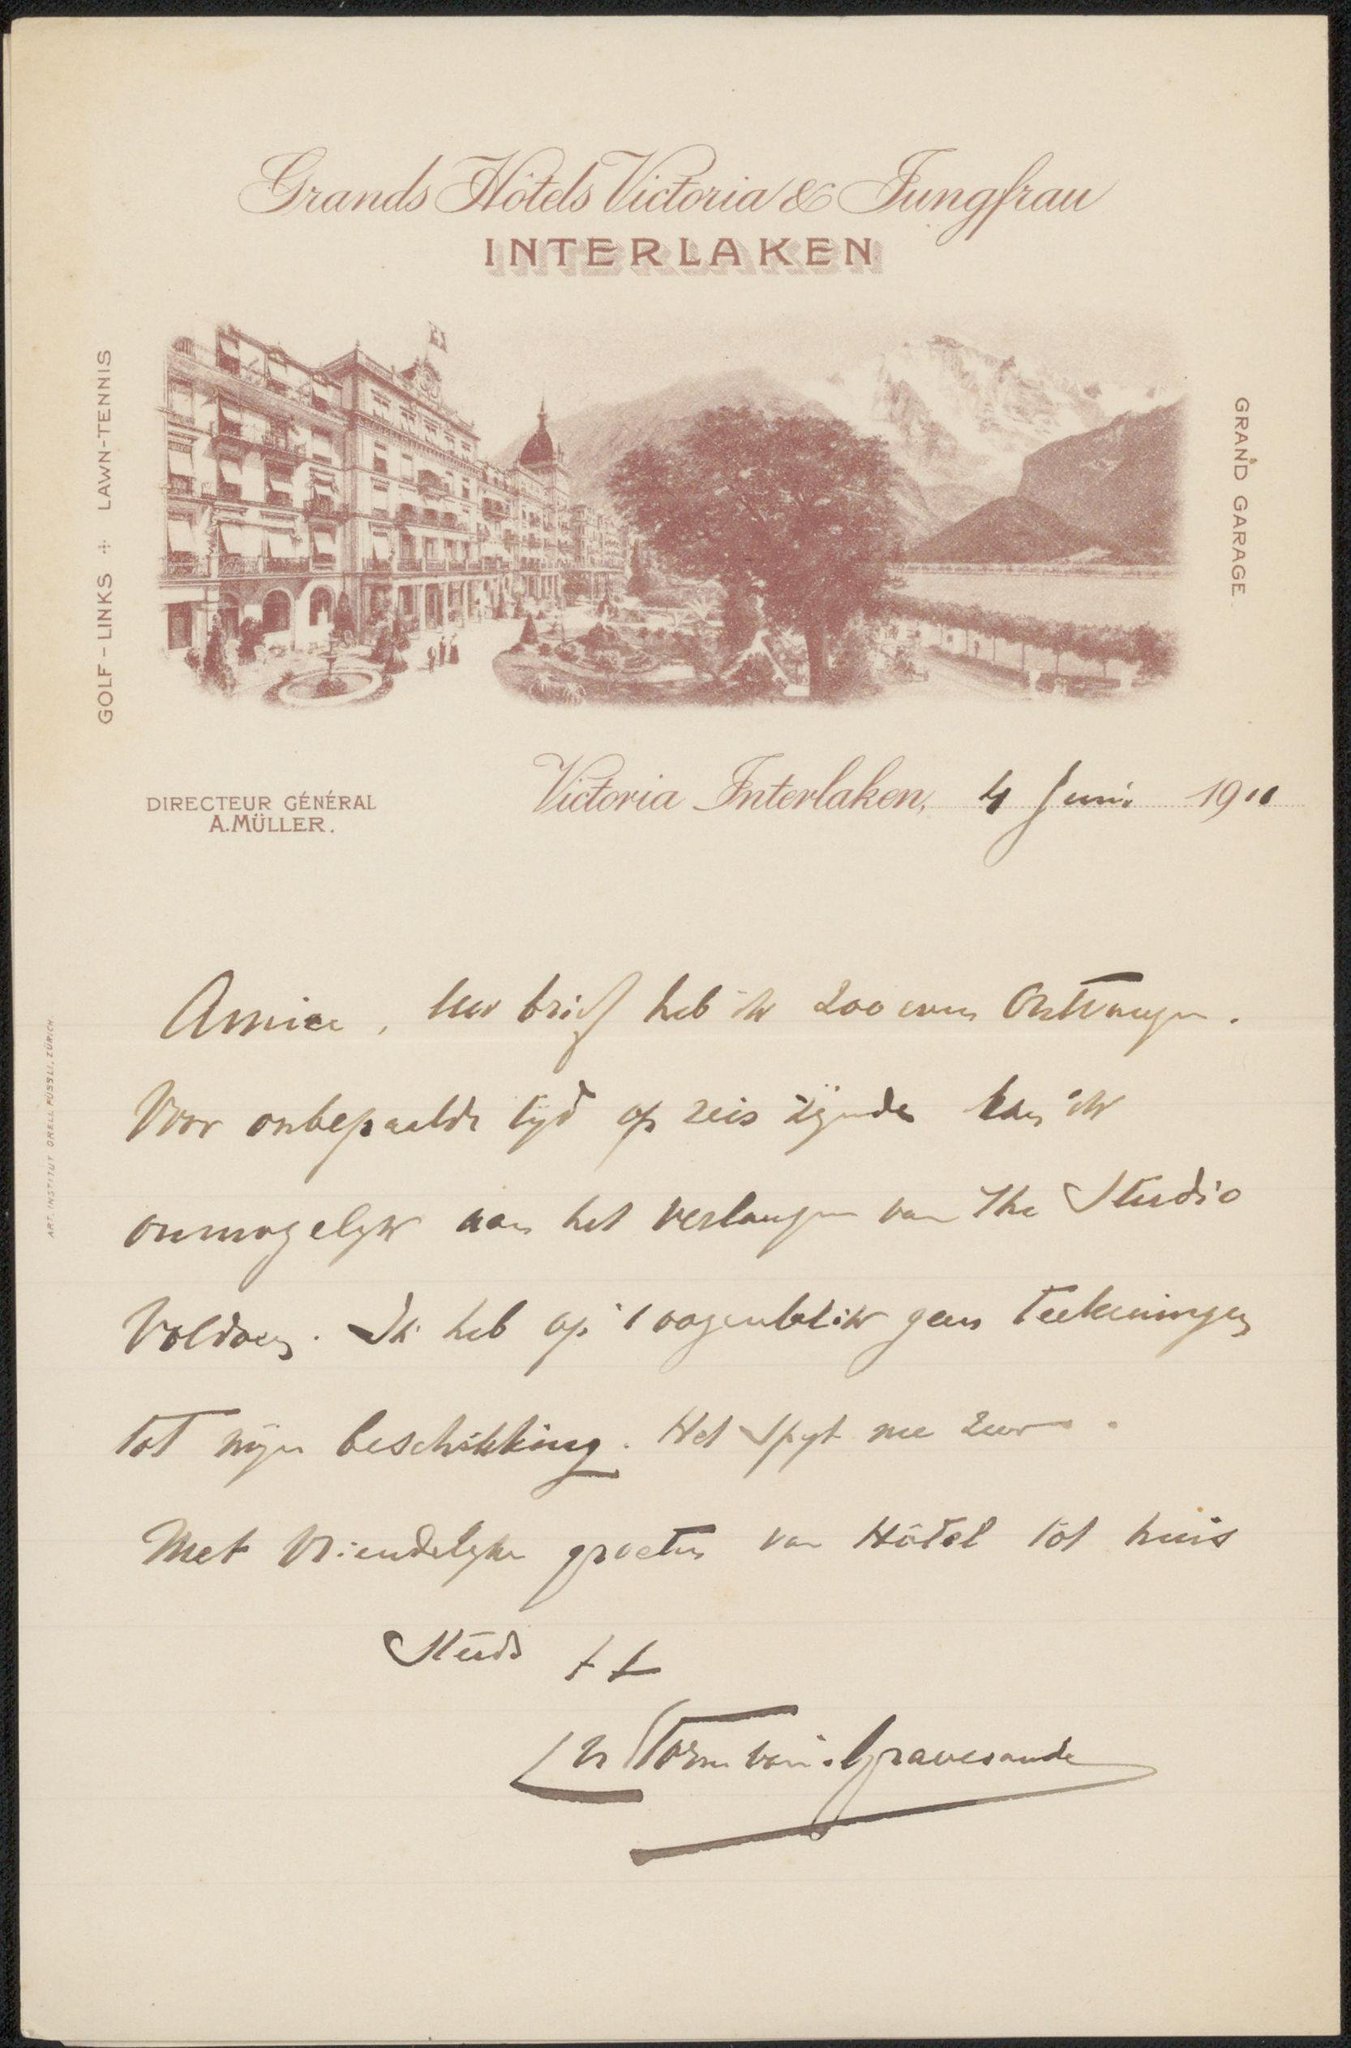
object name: letter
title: Brief aan Philip Zilcken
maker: carel nicolaas storm van s-gravesande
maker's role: draughtsman, print maker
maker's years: 1841-1924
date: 1911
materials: ink, paper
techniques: pen, printing, writing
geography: interlaken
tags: publisher, painter, philip zilcken, drawing, travelling; tourism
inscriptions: collector's mark: ‘RPK’